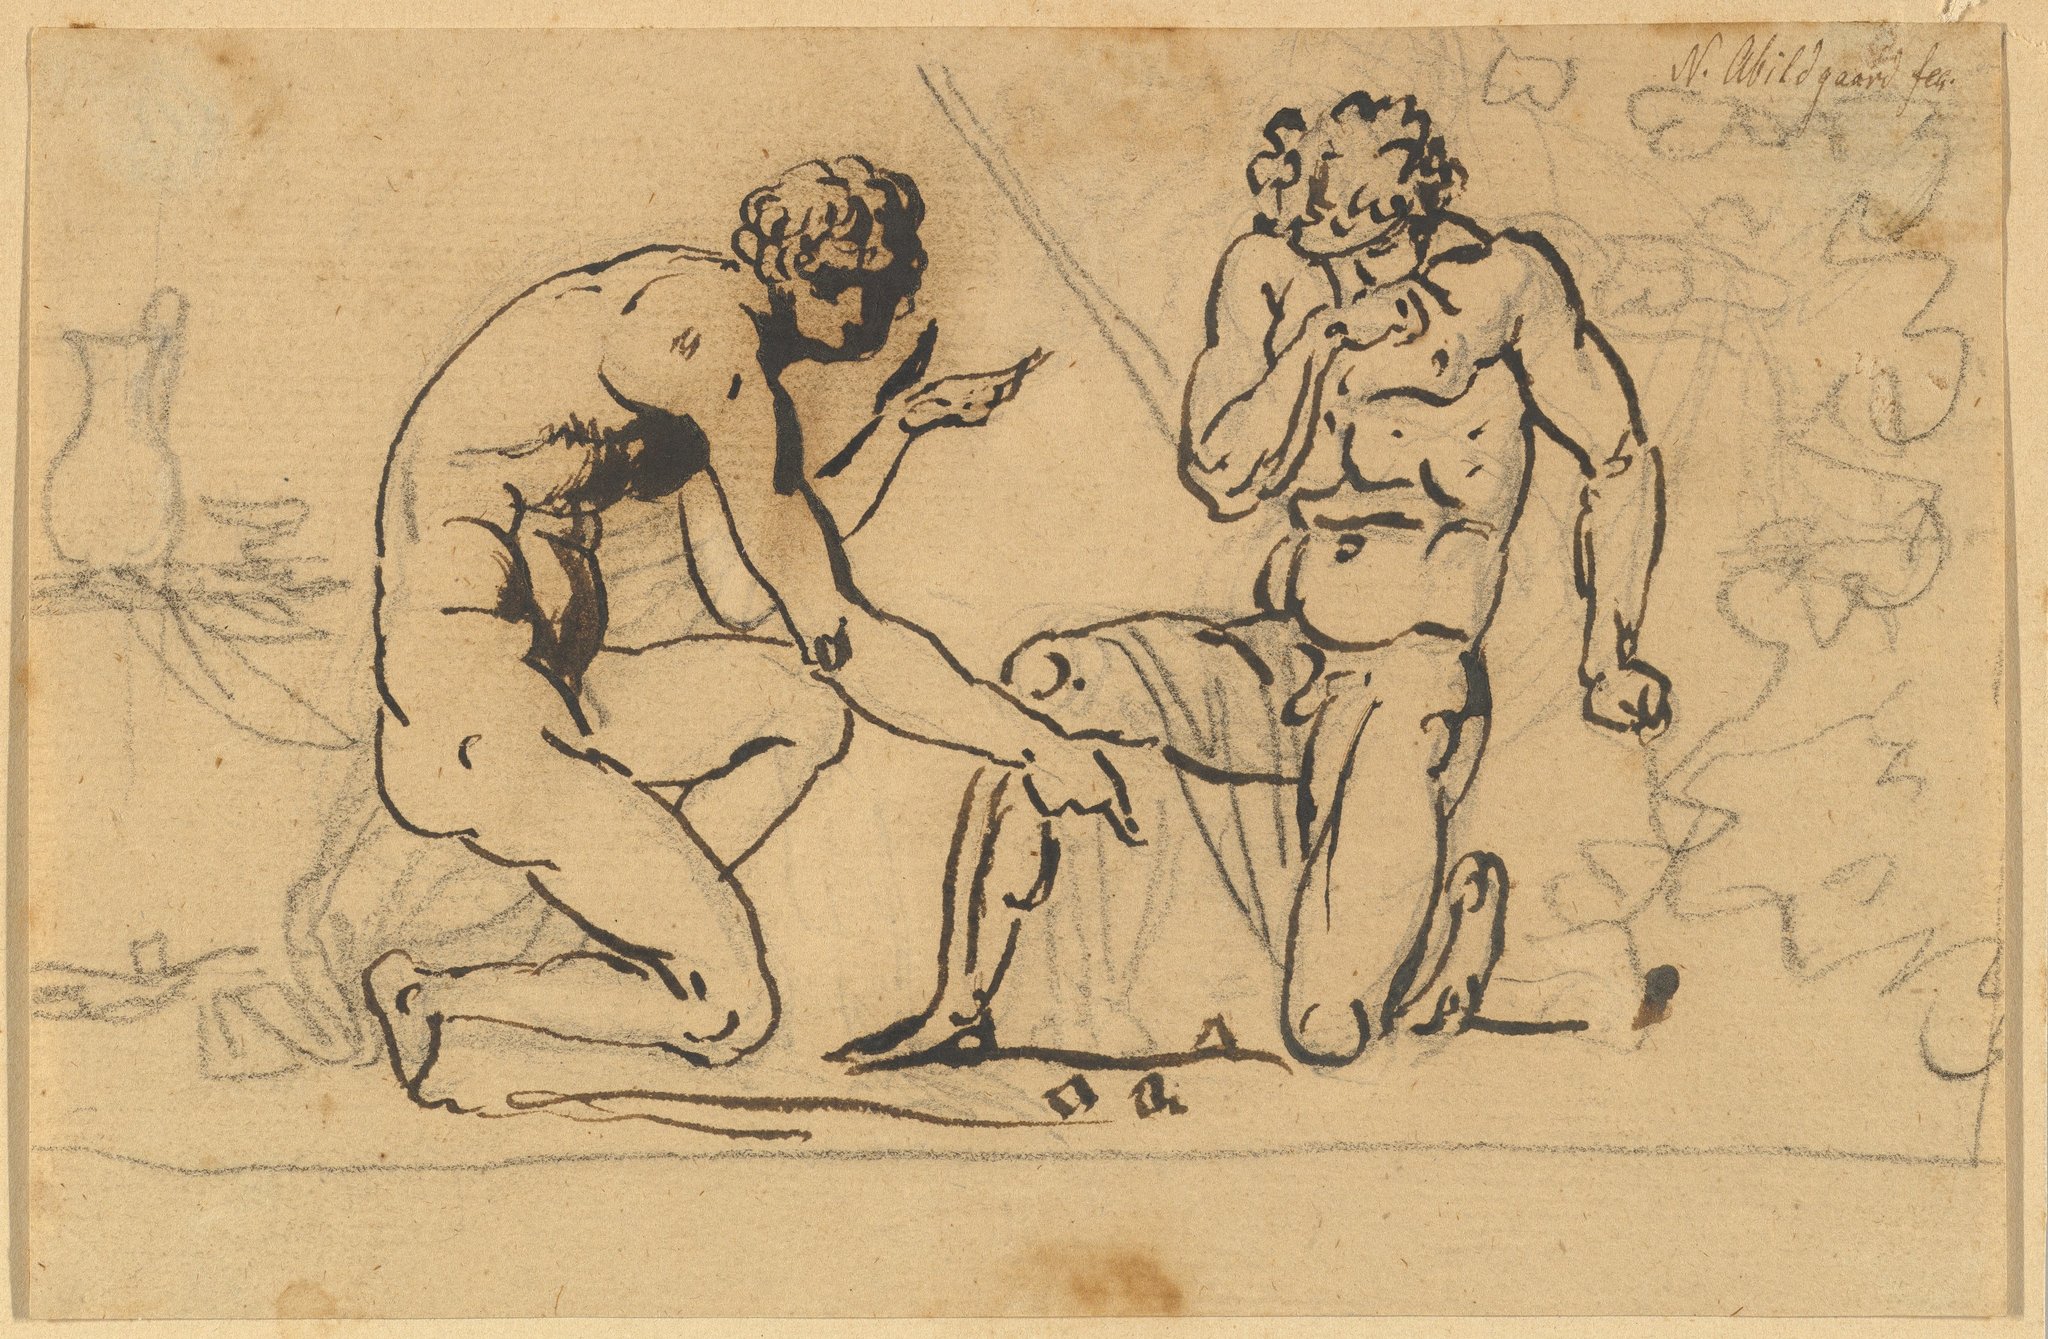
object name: drawing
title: Two Nude Men Playing with Dice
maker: nicolai abraham abildgaard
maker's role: artist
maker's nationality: danish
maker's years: 1743-1809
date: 1734-1833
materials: graphite, ink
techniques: pen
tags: male nudes,dice,playing